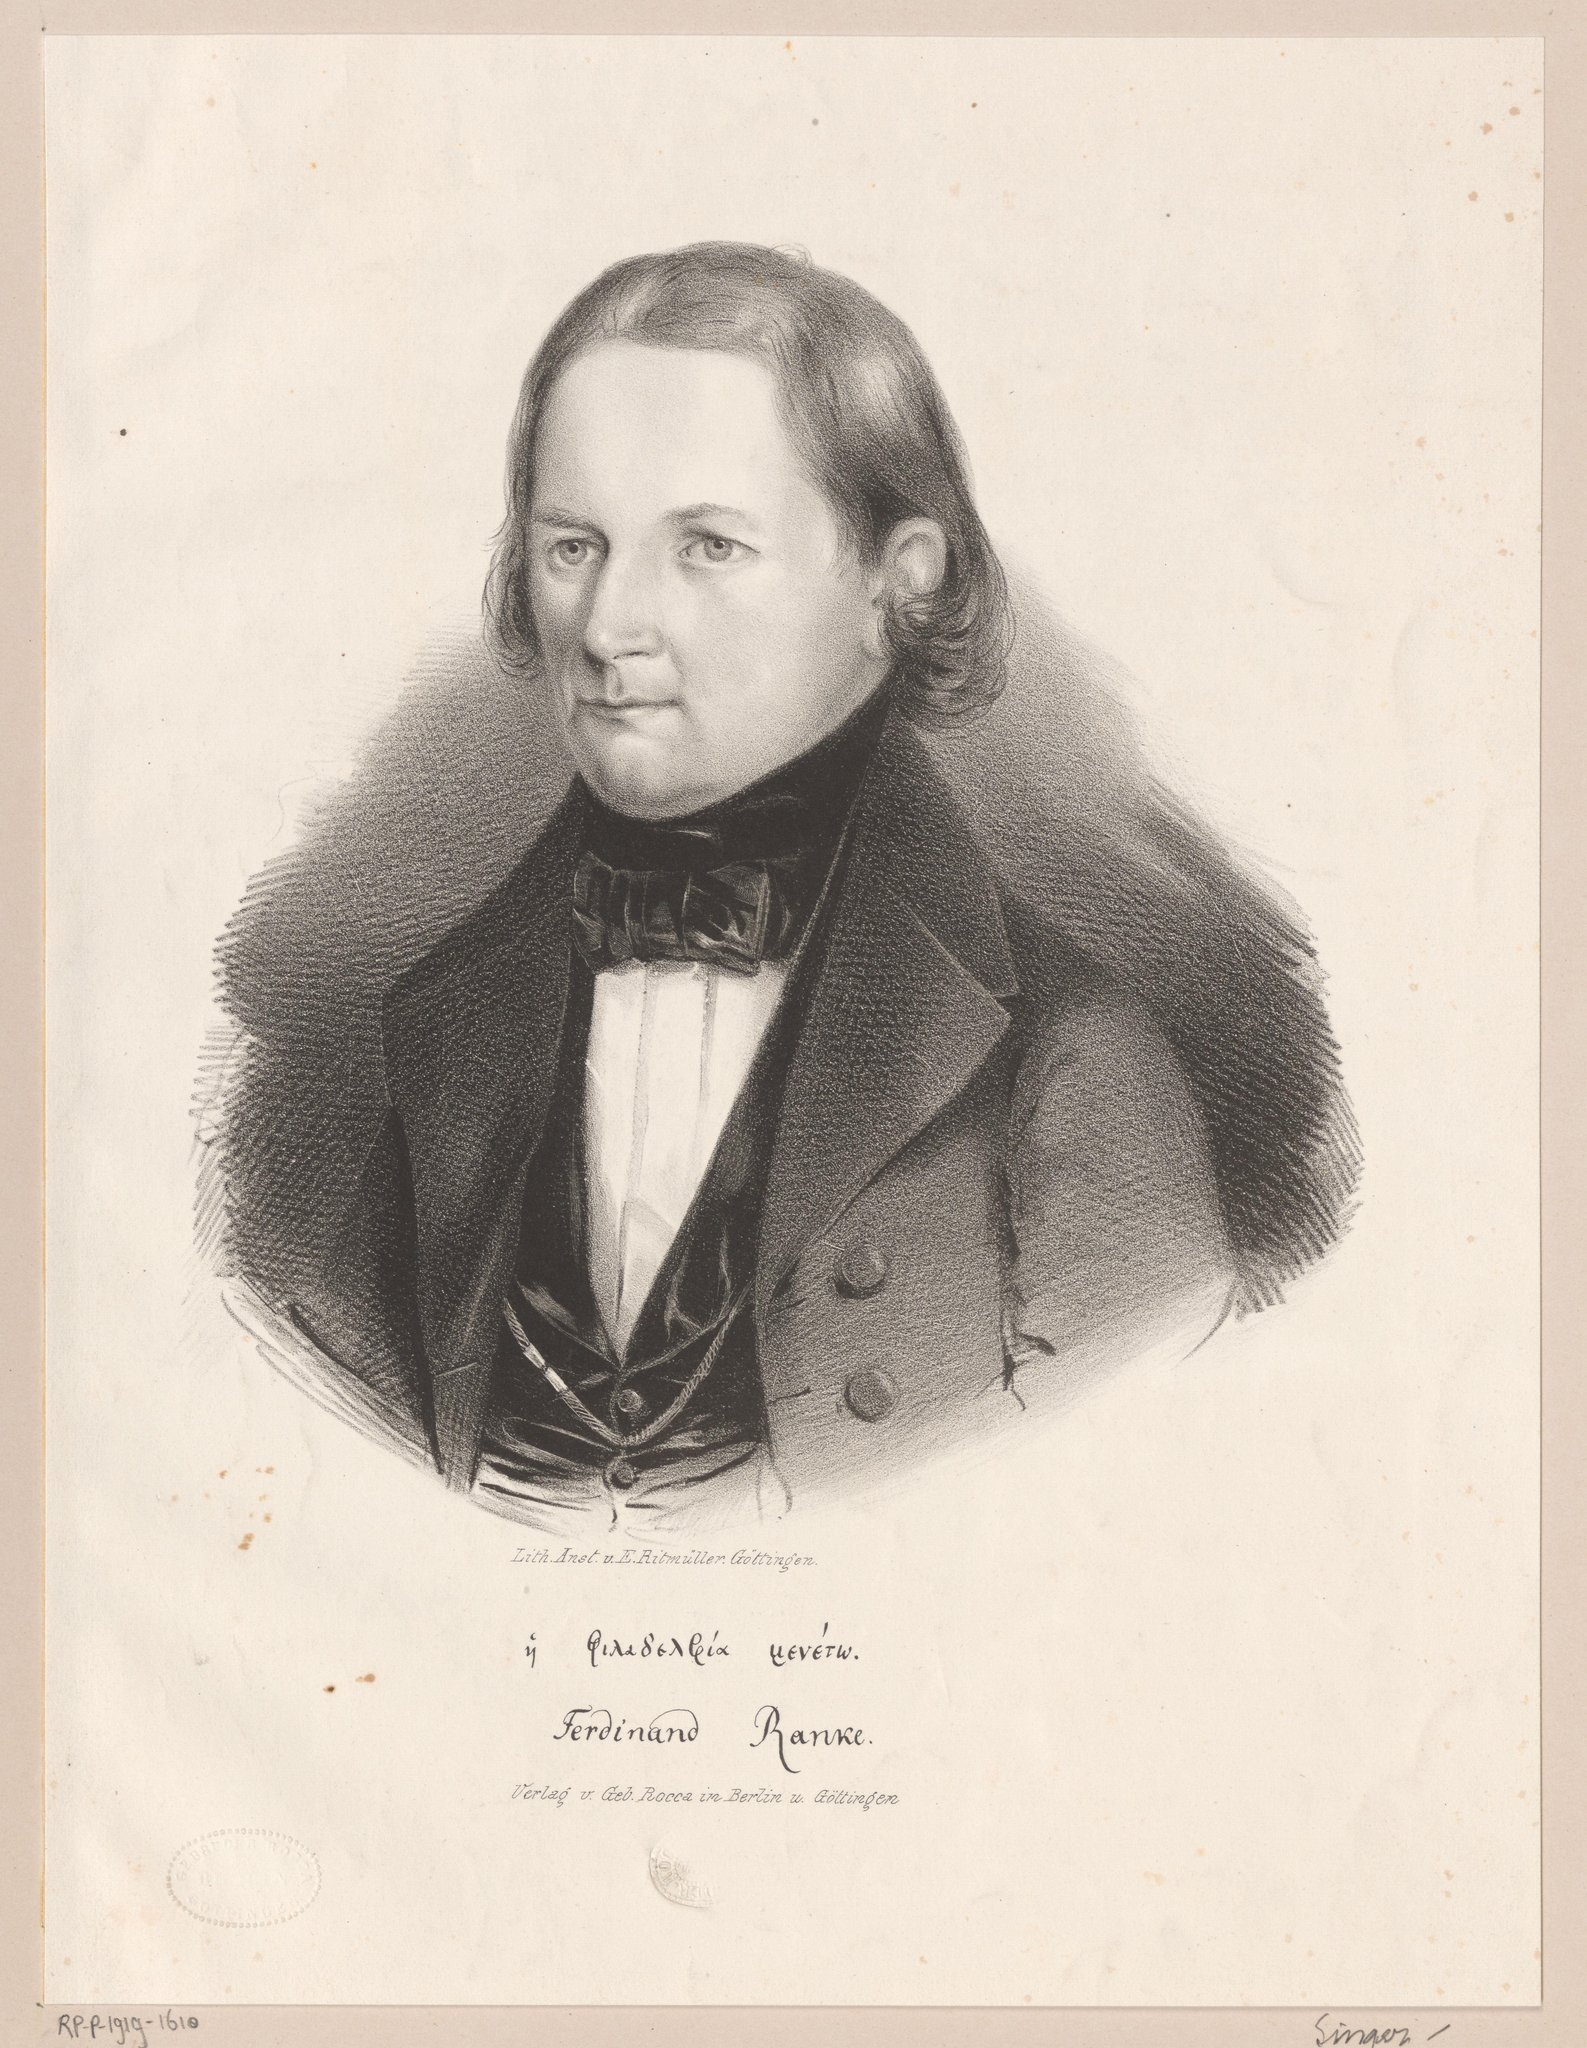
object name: print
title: Portret van Karl Ferdinand Ranke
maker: friedrich eduard ritmüller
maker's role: printer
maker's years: 1805-1869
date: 1830-1863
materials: paper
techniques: lithograph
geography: berlin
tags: historical persons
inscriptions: collector's mark: Lugt 2228, check stamp: Lugt 5514, check stamp: Lugt 2141c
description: Onder het portret een facsimile van de handtekening van de geportretteerde.